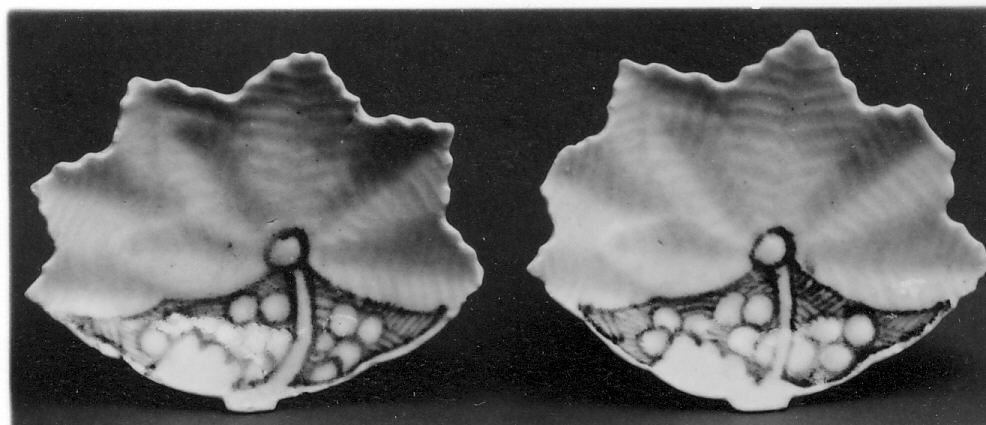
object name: dish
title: Dish in a Leaf Shape with Wave and Molded Double Leaf Design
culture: japanese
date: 1634-1666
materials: porcelain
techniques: underglaze